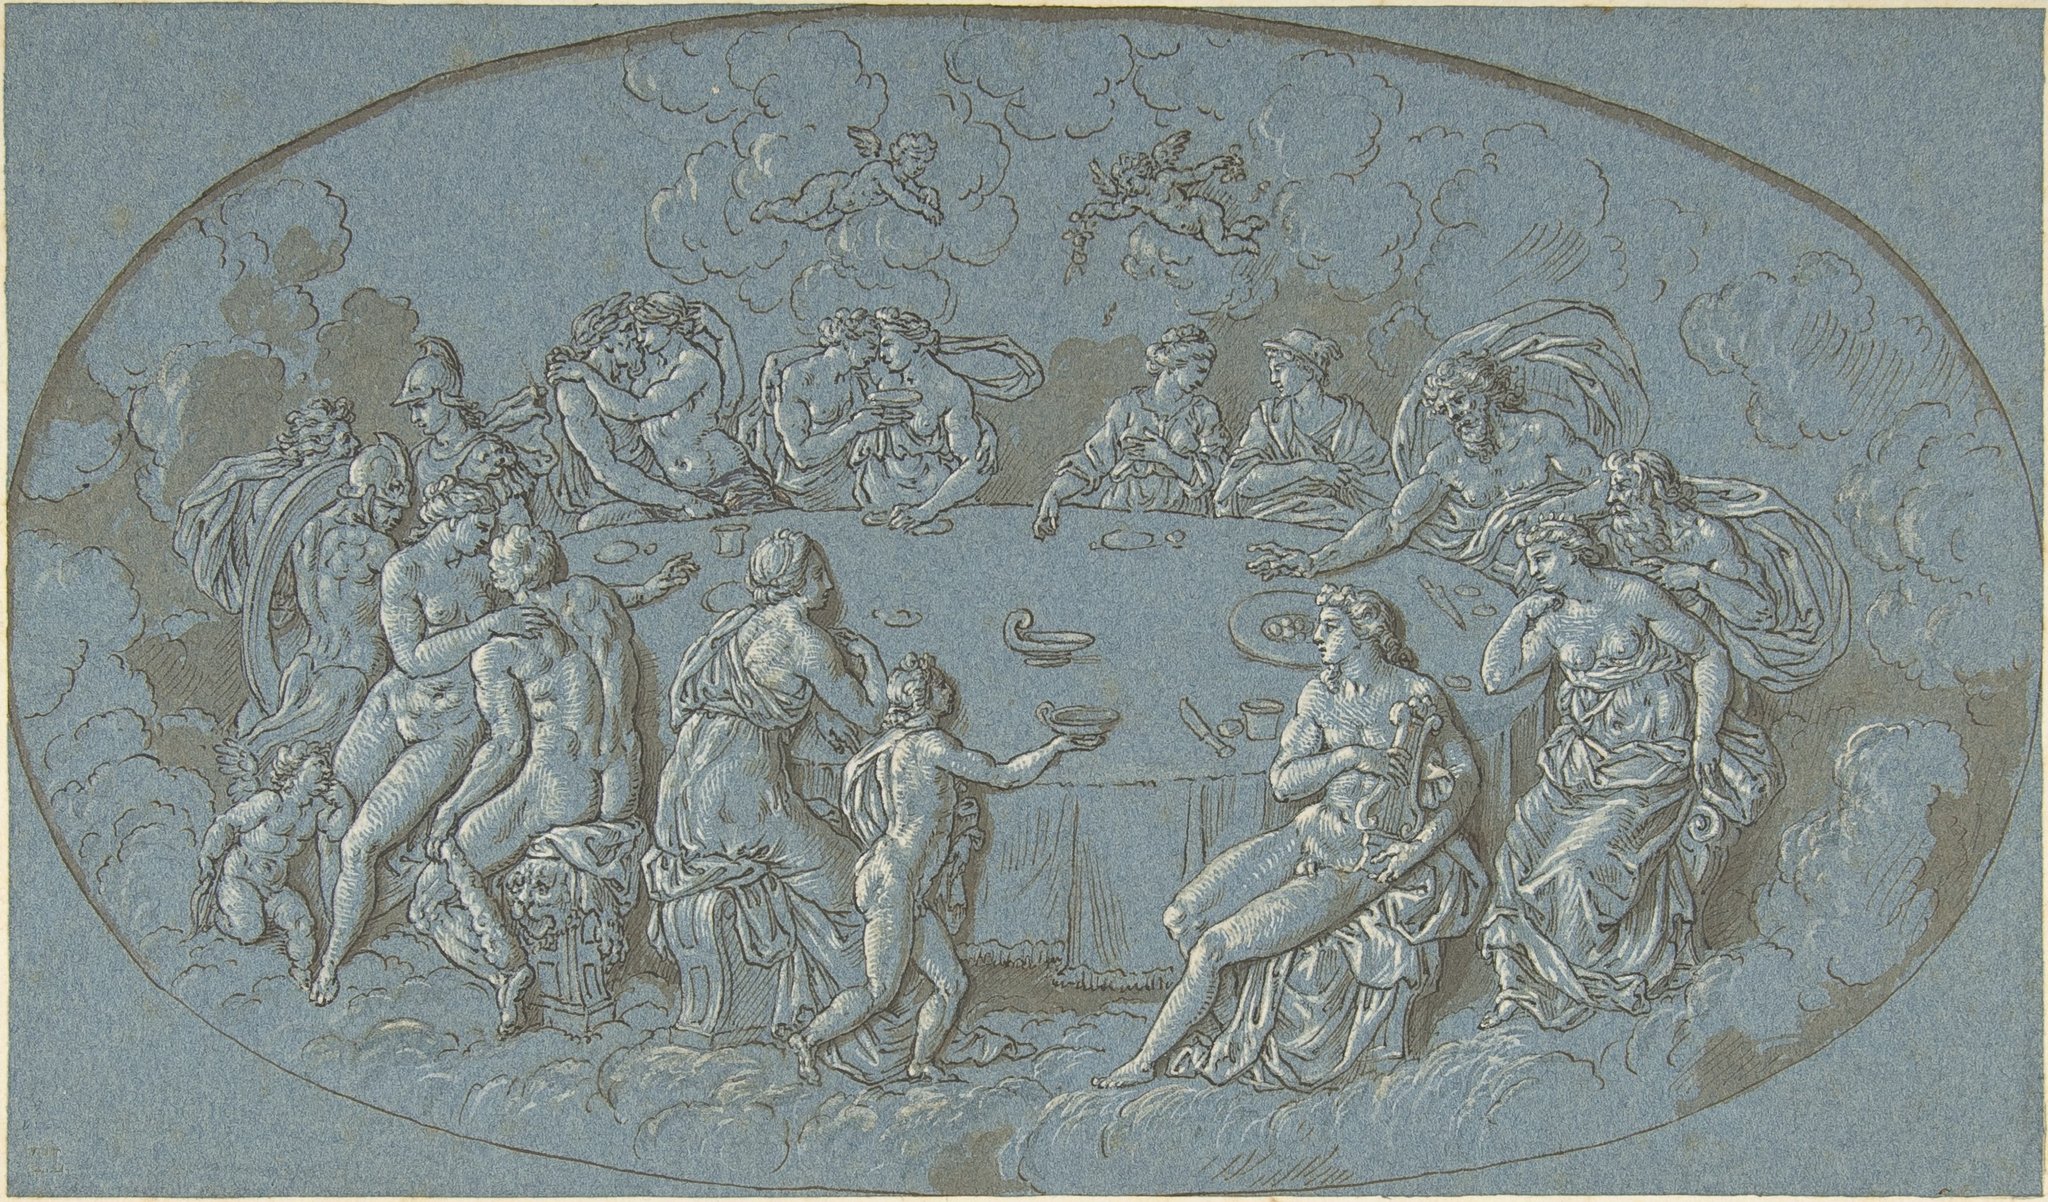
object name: drawing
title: Feast of the Gods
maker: bernard picart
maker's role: artist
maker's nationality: french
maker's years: 1673-1733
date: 1667-1733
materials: ink, paper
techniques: brush, heightening, pen, wash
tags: male nudes,female nudes,tables